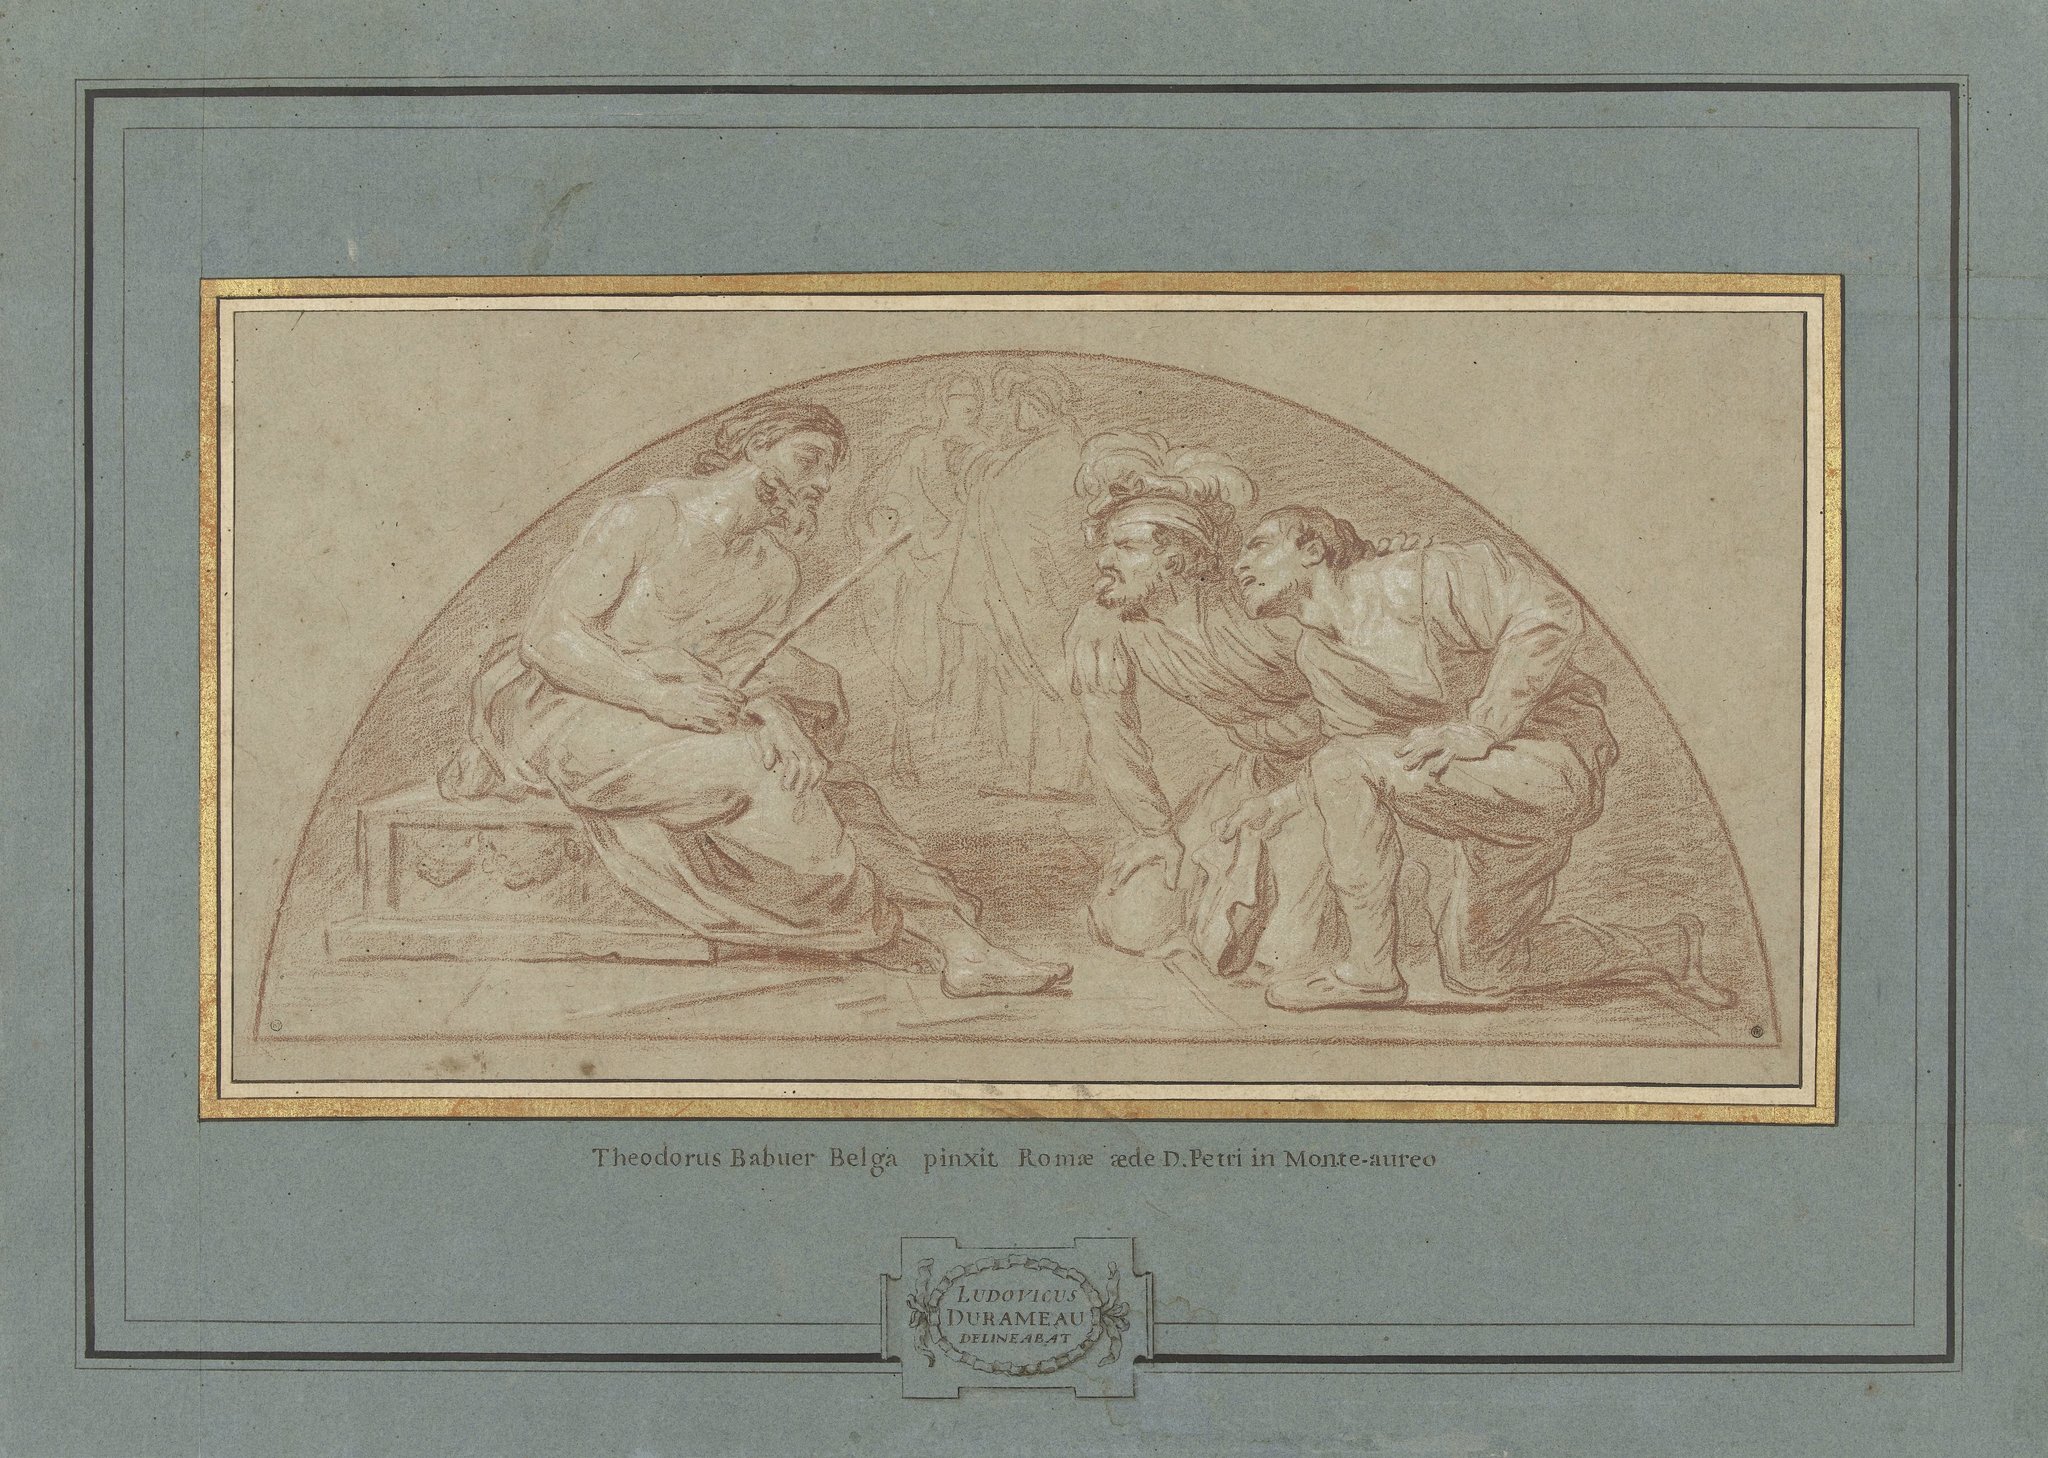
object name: drawing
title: Bespotting van Christus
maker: louis jean jacques durameau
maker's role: draughtsman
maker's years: 1733-1796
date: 1743-1796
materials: chalk, paper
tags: in pilate's palace christ is mocked by soldiers (luke 22:63-65)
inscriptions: annotation, verso, lower centre, pencil: ‘Louis Jean Jacques Durameau (1733-1796) / Collection Mariette Lugt 1852’, collector's mark: Lugt 2228, annotation, on the old mount, lower centre, pen and brown ink: ‘Theodorus Babuer Belga pinxit Romae aede D. Petri in Monte-aureo // LUDOVICUS / DURAMEAU / DELINEABAT’, collector's mark, recto, lower left and lower right: Lugt 2097, annotation, verso, lower left, pencil: ‘gutt’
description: De bespotting van Christus naar een geschilderde lunet door David de Haen (ca. 1585-1622), vroeger toegeschreven aan Dirk van Baburen, in S. Pietro in Montorio te Rome.